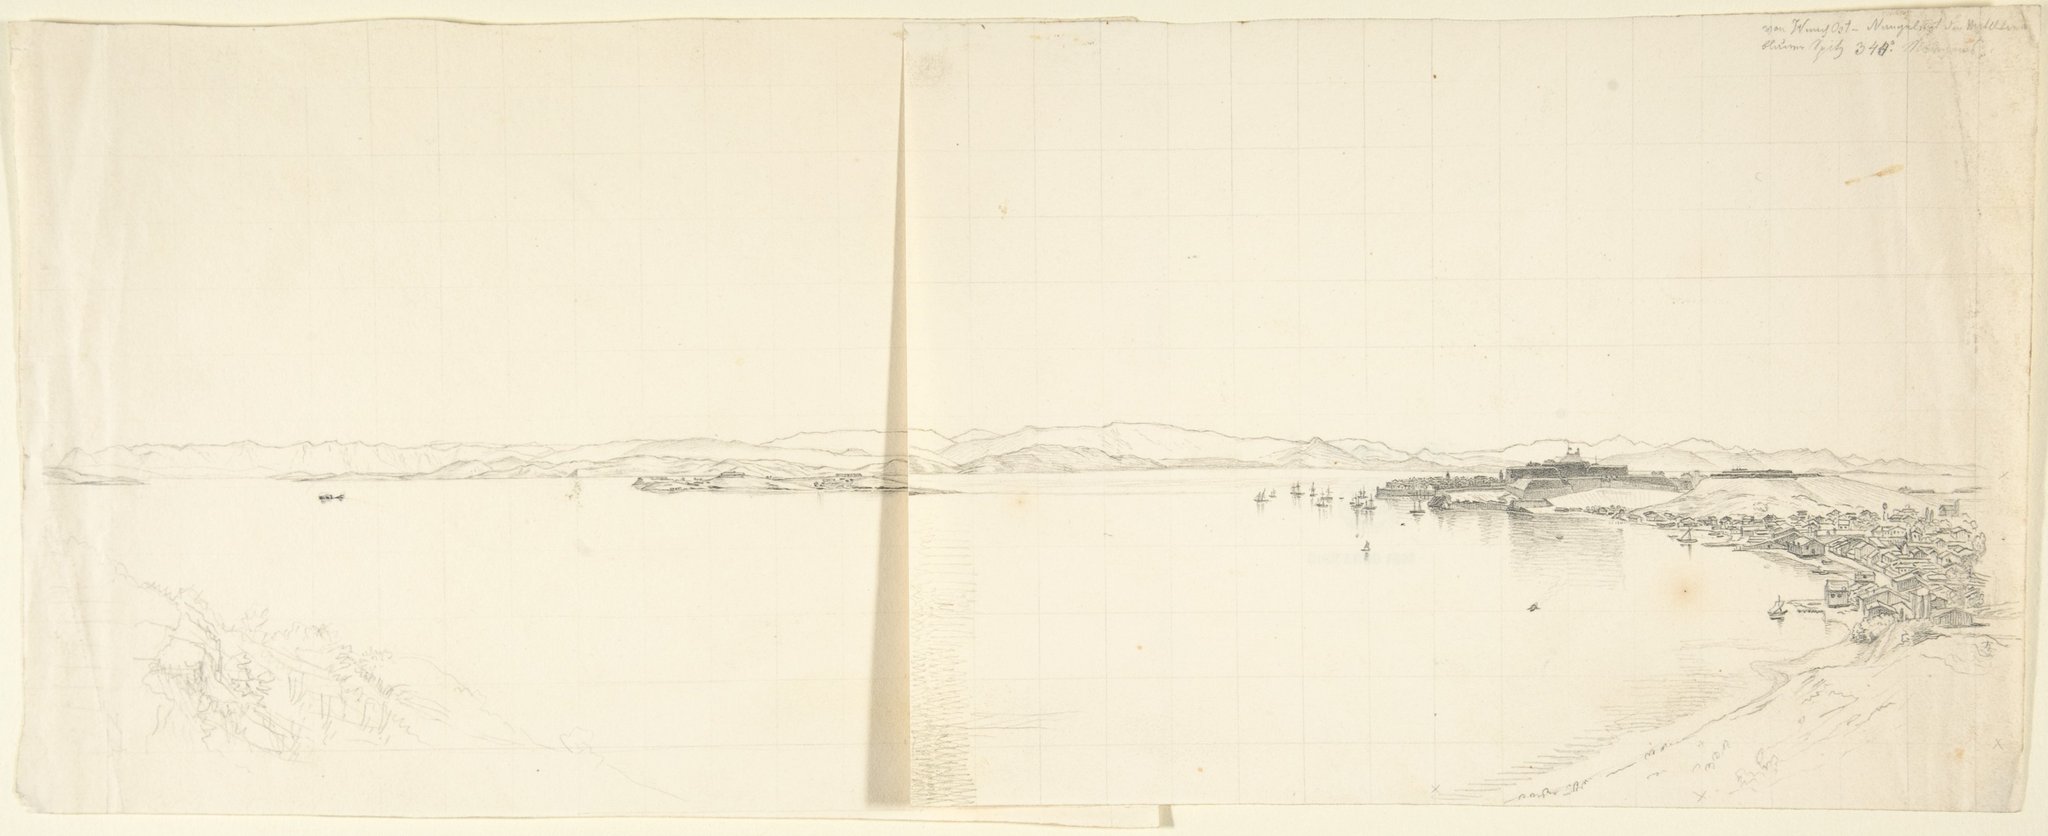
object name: drawing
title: View of a Bay and Mountains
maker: franz von hauslab the younger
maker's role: artist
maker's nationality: austrian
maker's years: 1798-1883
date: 1801-1900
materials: pencil, paper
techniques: drawing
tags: landscapes